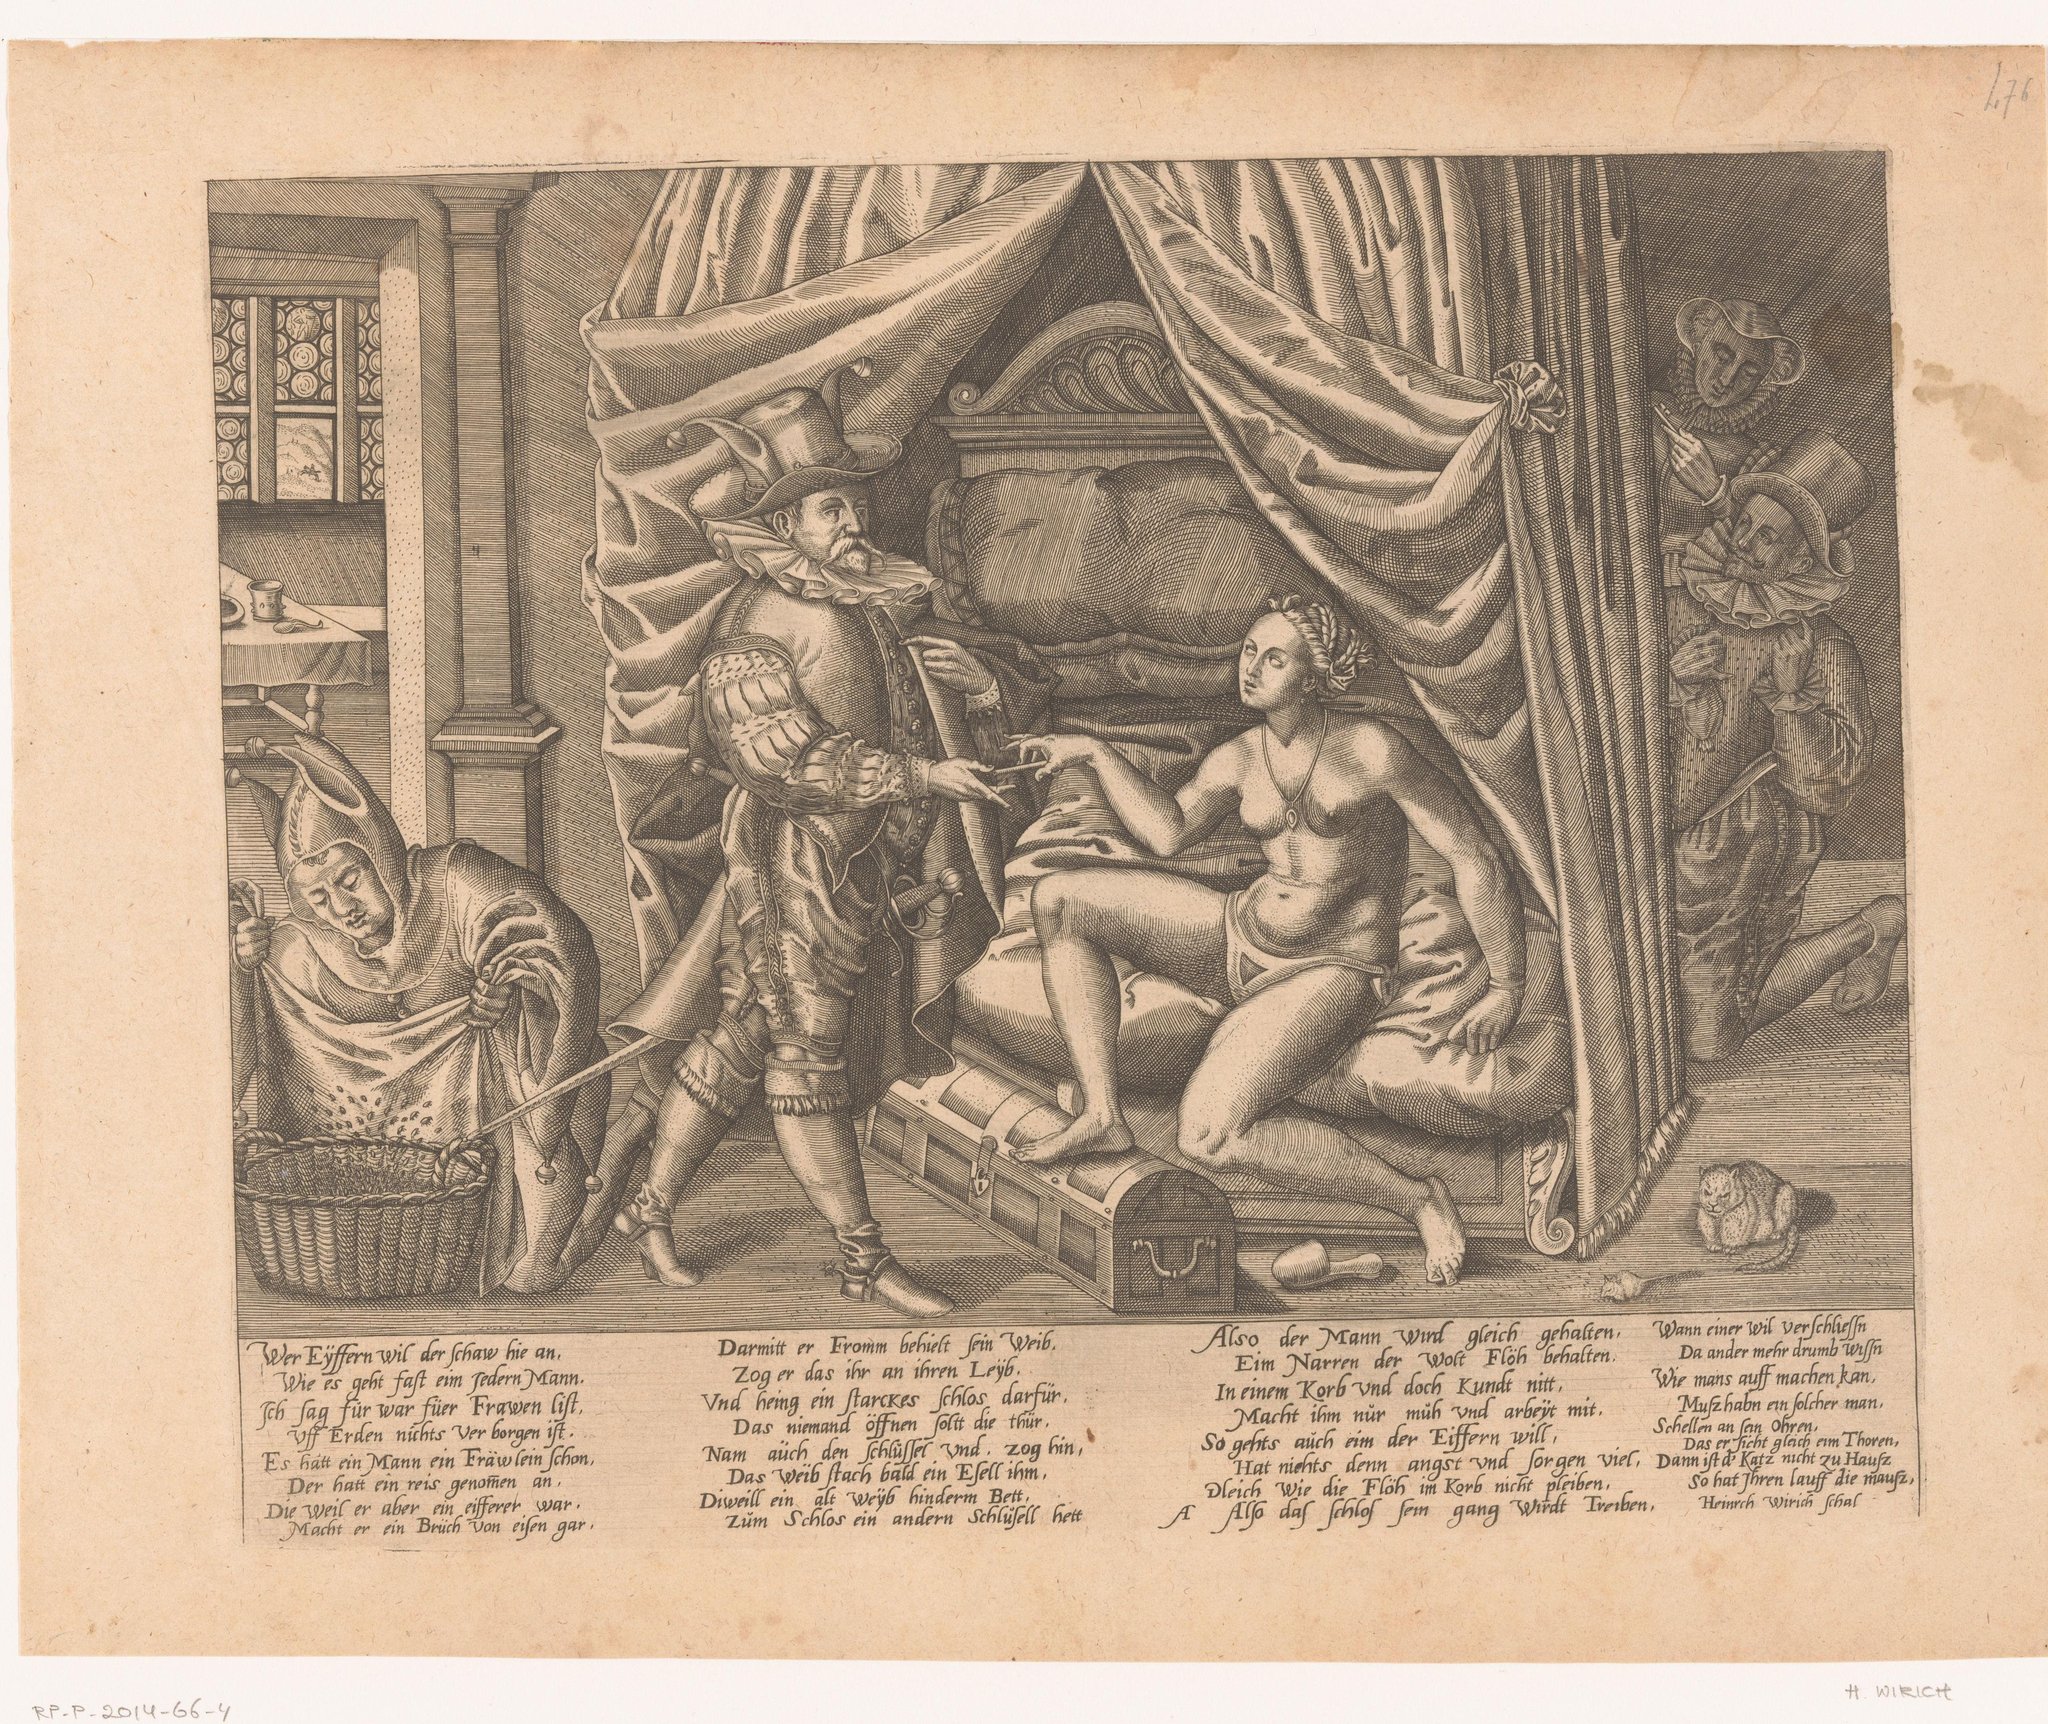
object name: print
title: Allegory of a Man Locking a Woman into a Chastity Belt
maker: heinrich wirich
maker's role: print maker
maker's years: -1600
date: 1575-1600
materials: paper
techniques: engraving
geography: germany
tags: partner deceived, chastity belt, insects: flea, fool, simpleton, numskull, historical persons, proverbs, sayings, etc., fool's cap, adultery, prostitution, cat and mouse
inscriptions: collector's mark: Lugt 2228, collector's mark: Lugt 2760, collector's mark: Lugt 2228, signature: ‘Heinrch Wirich schal’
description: When the cat is away, the mice will play. The nude woman hands the key to her chastity belt to her husband, who is about to leave on a trip. The maidservant, however, stands at the ready with a spare key. Is the man next to her the lady’s lover? A jester vainly tries to keep fleas in a basket, a reference to the foolishness of the husband, whose hat resembles his fool’s cap.